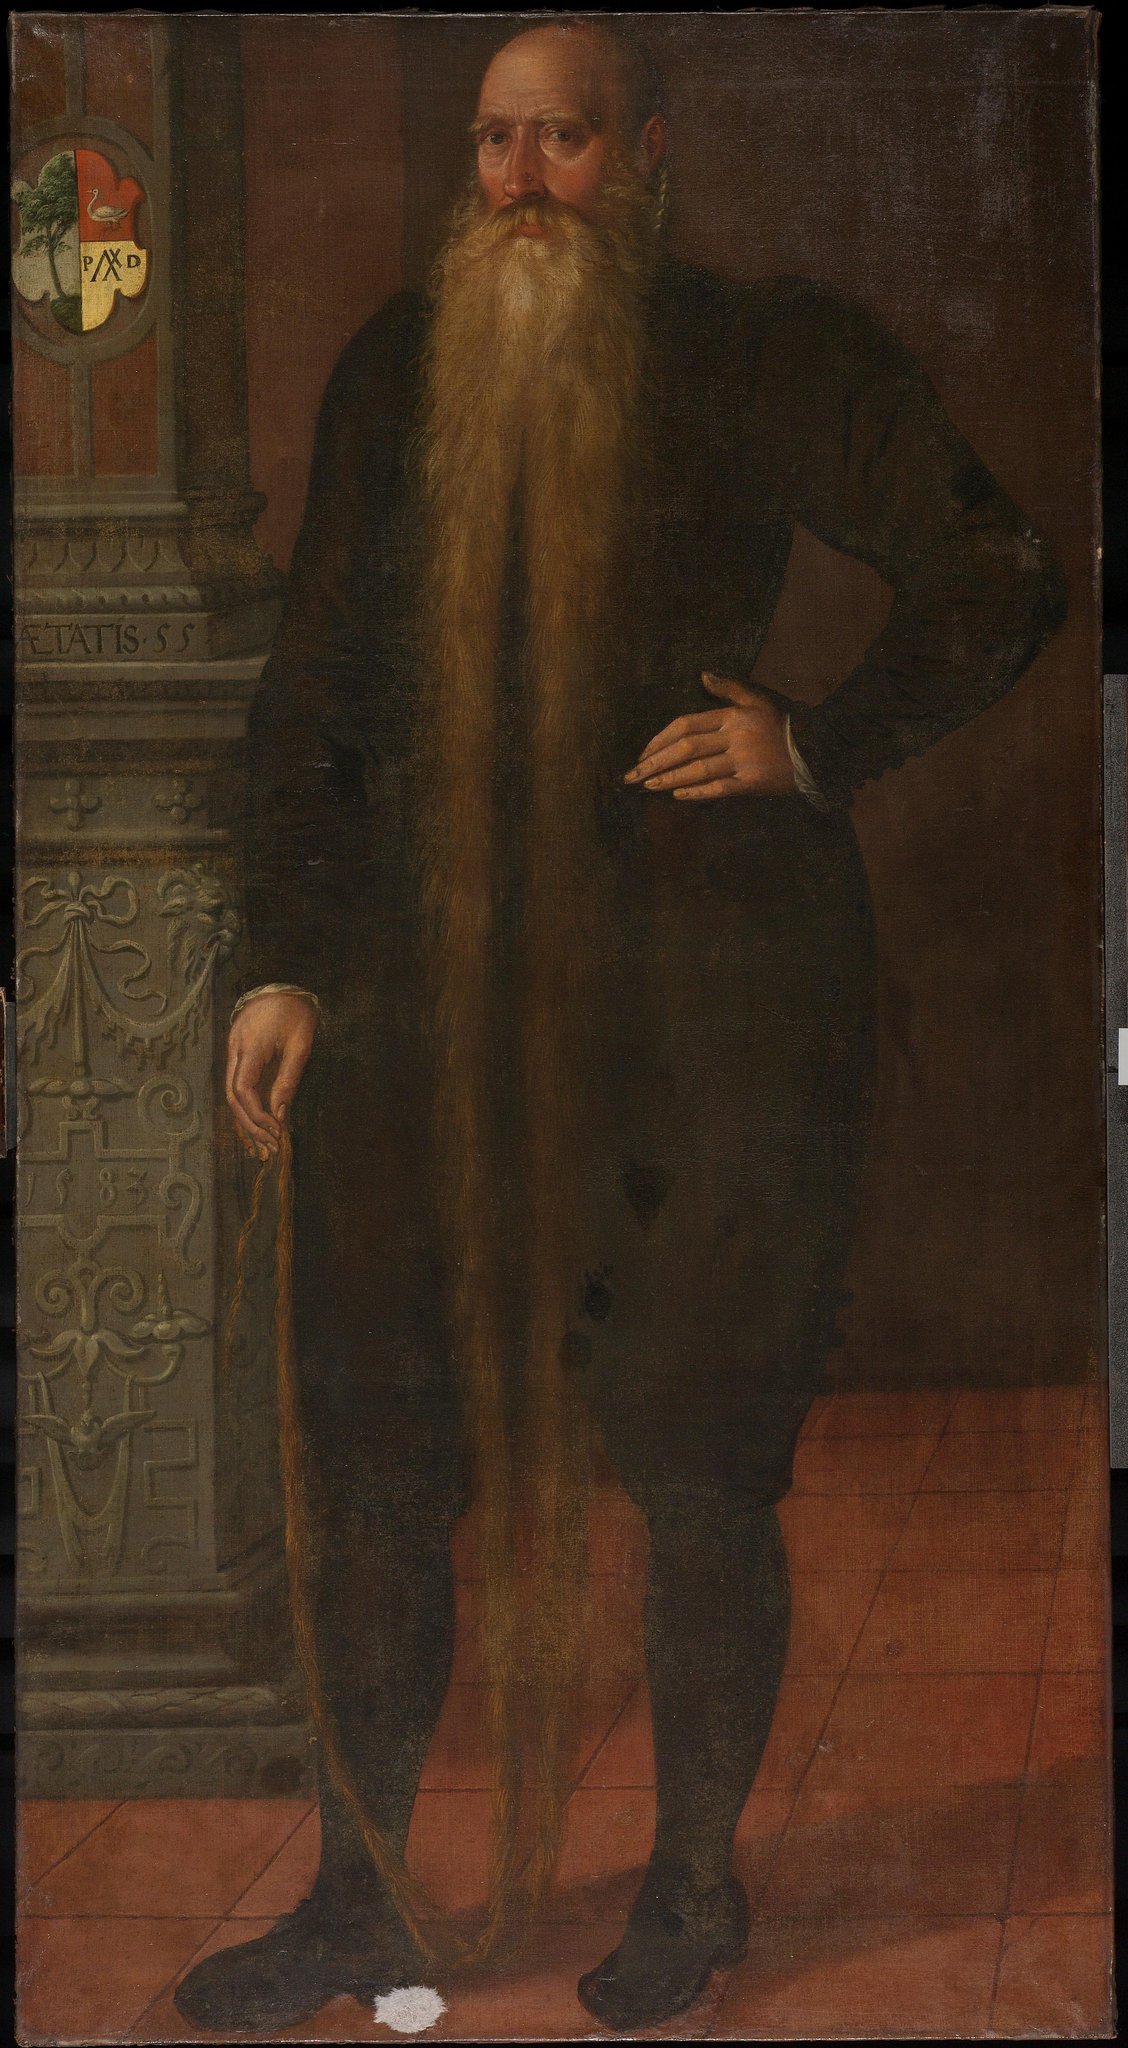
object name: painting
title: Portrait of Pieter Dircksz, called Long Beard, Council Member of the Orphan Chamber in Edam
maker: aert pietersz.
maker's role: draughtsman, painter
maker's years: 1550-1612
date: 1583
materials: canvas, oil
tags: historical persons, person with big beard, beard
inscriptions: inscription and date: ‘1583 AETATIS. 55’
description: Portret van Pieter Dircksz (1528-1606), genaamd Langbaard of Langebaard, weesmeester van Edam. Staande, ten voeten uit, met de rechterhand het uiteinde van de baard vasthoudend, de linkerhand in de zij. Links een zuil met een basement versierd met rolwerk, festoenen en linten; bovenaan het familiewapen.